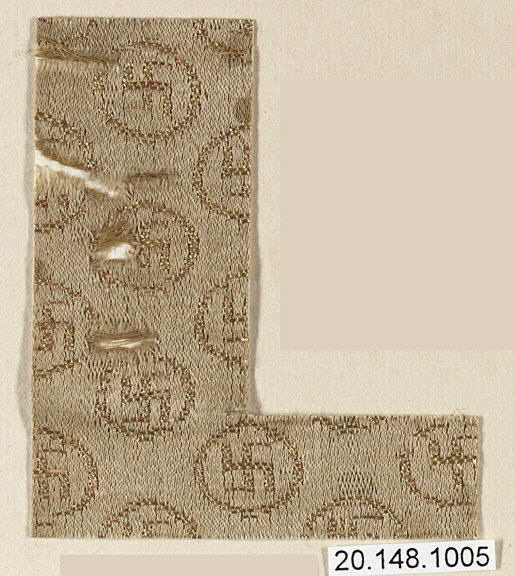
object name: piece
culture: japanese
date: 1701-1800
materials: silk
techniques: compound weave